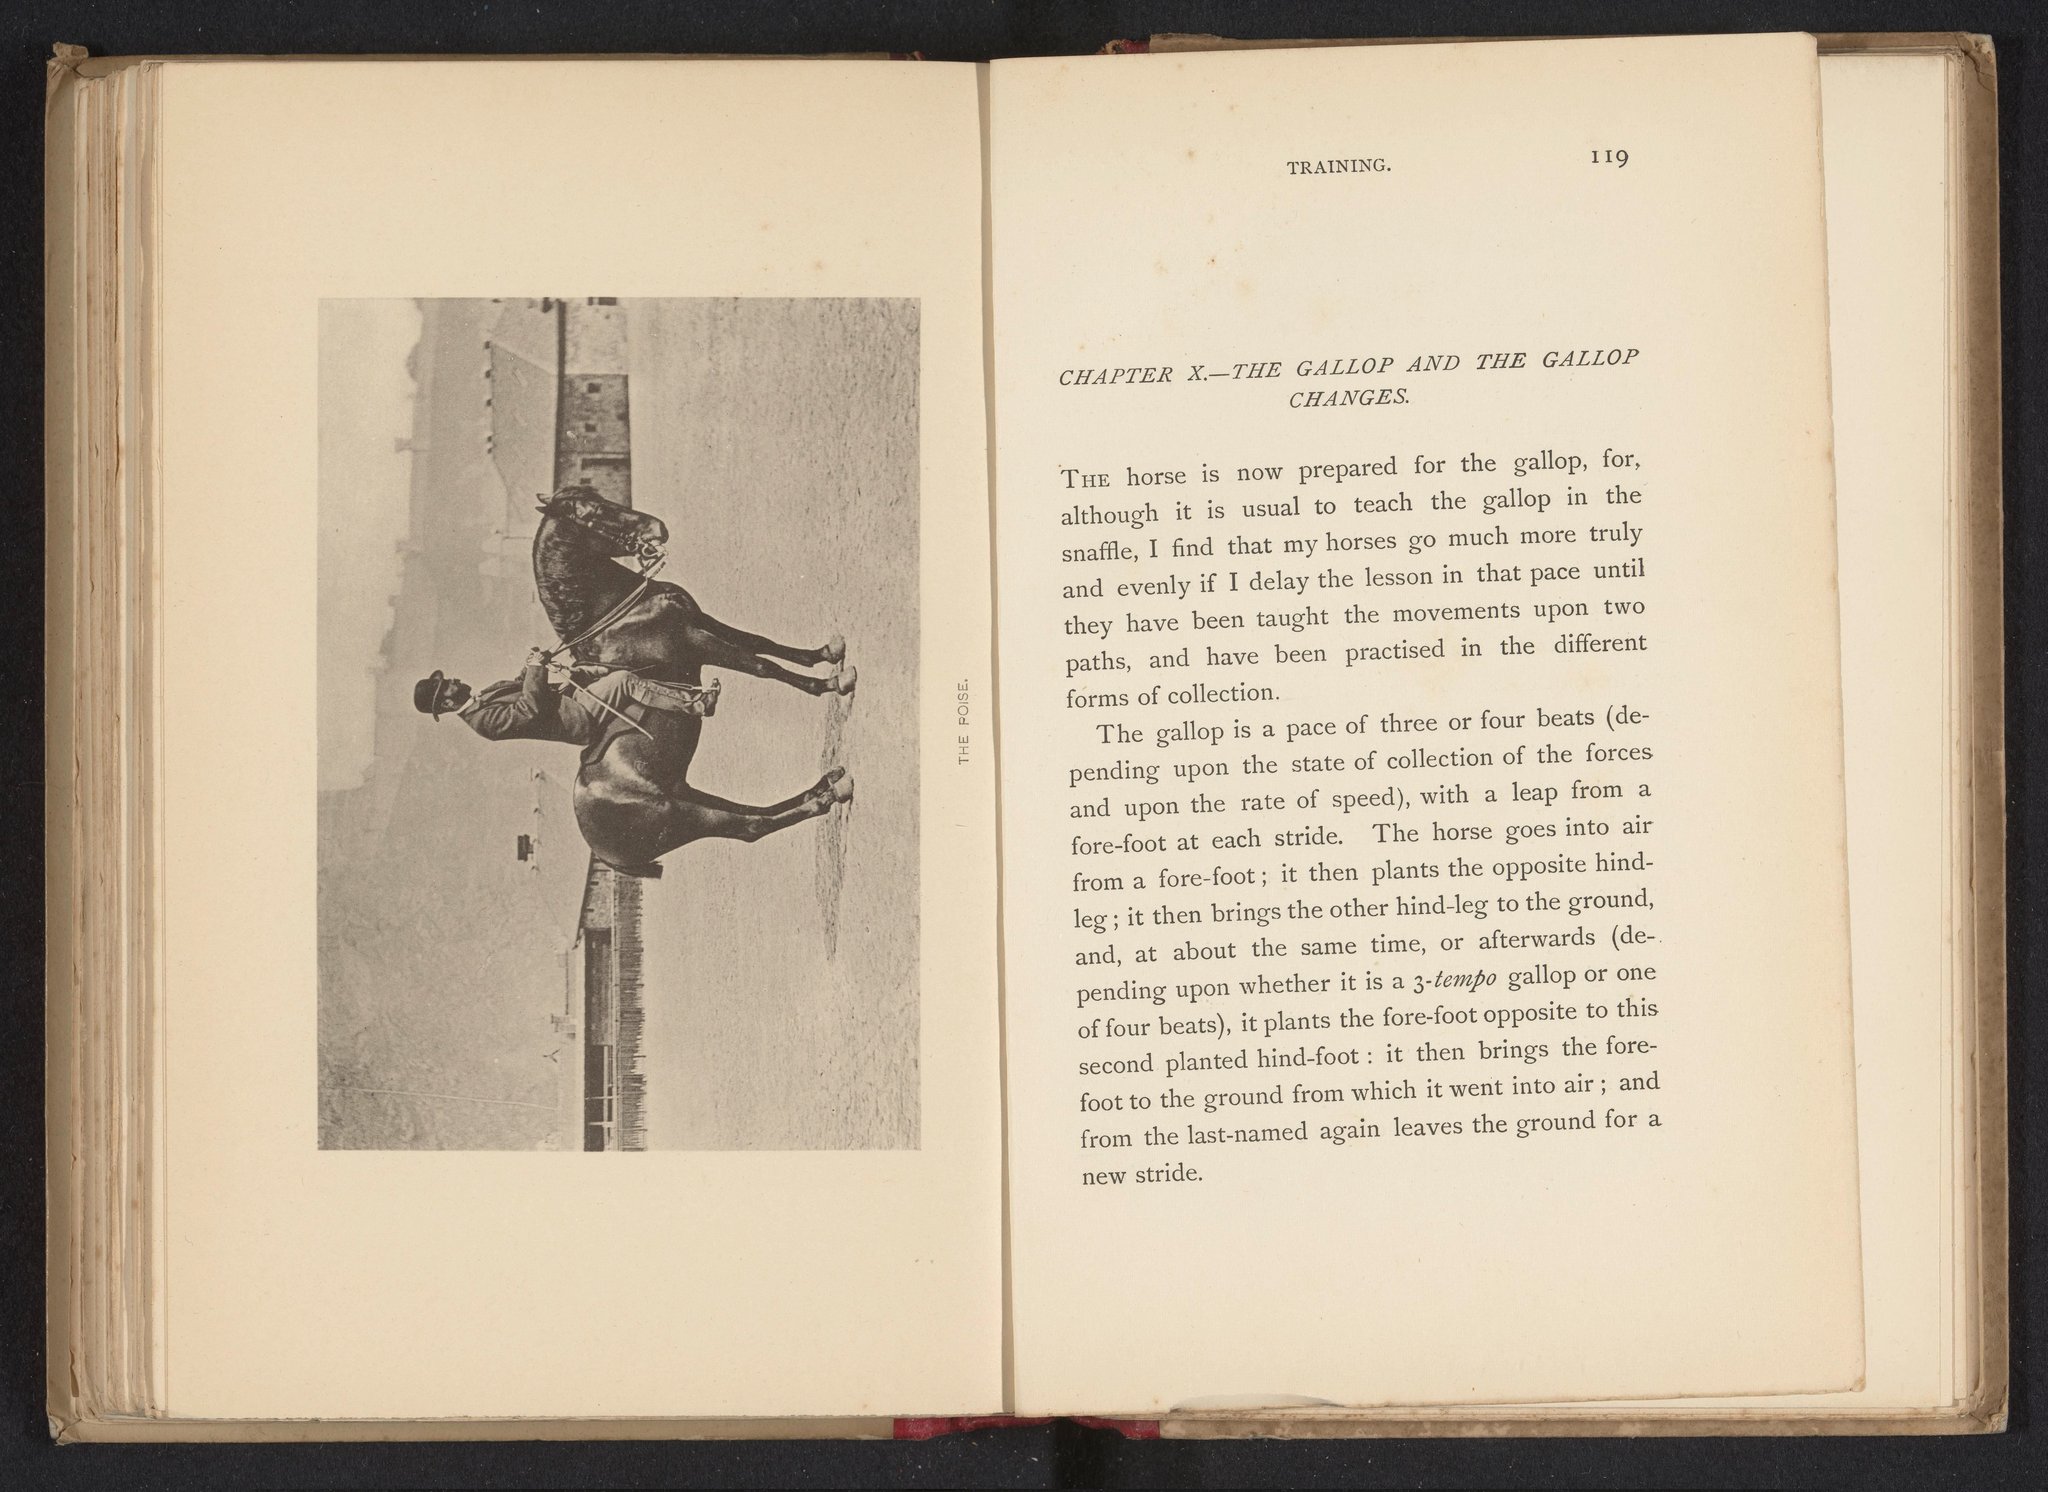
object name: page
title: Man op een paard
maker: alexander nicol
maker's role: fotograaf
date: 1879-1889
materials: paper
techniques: photograph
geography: edinburgh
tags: riding a horse, ass, or mule; rider, horseman, head-gear: bowler hat, horse